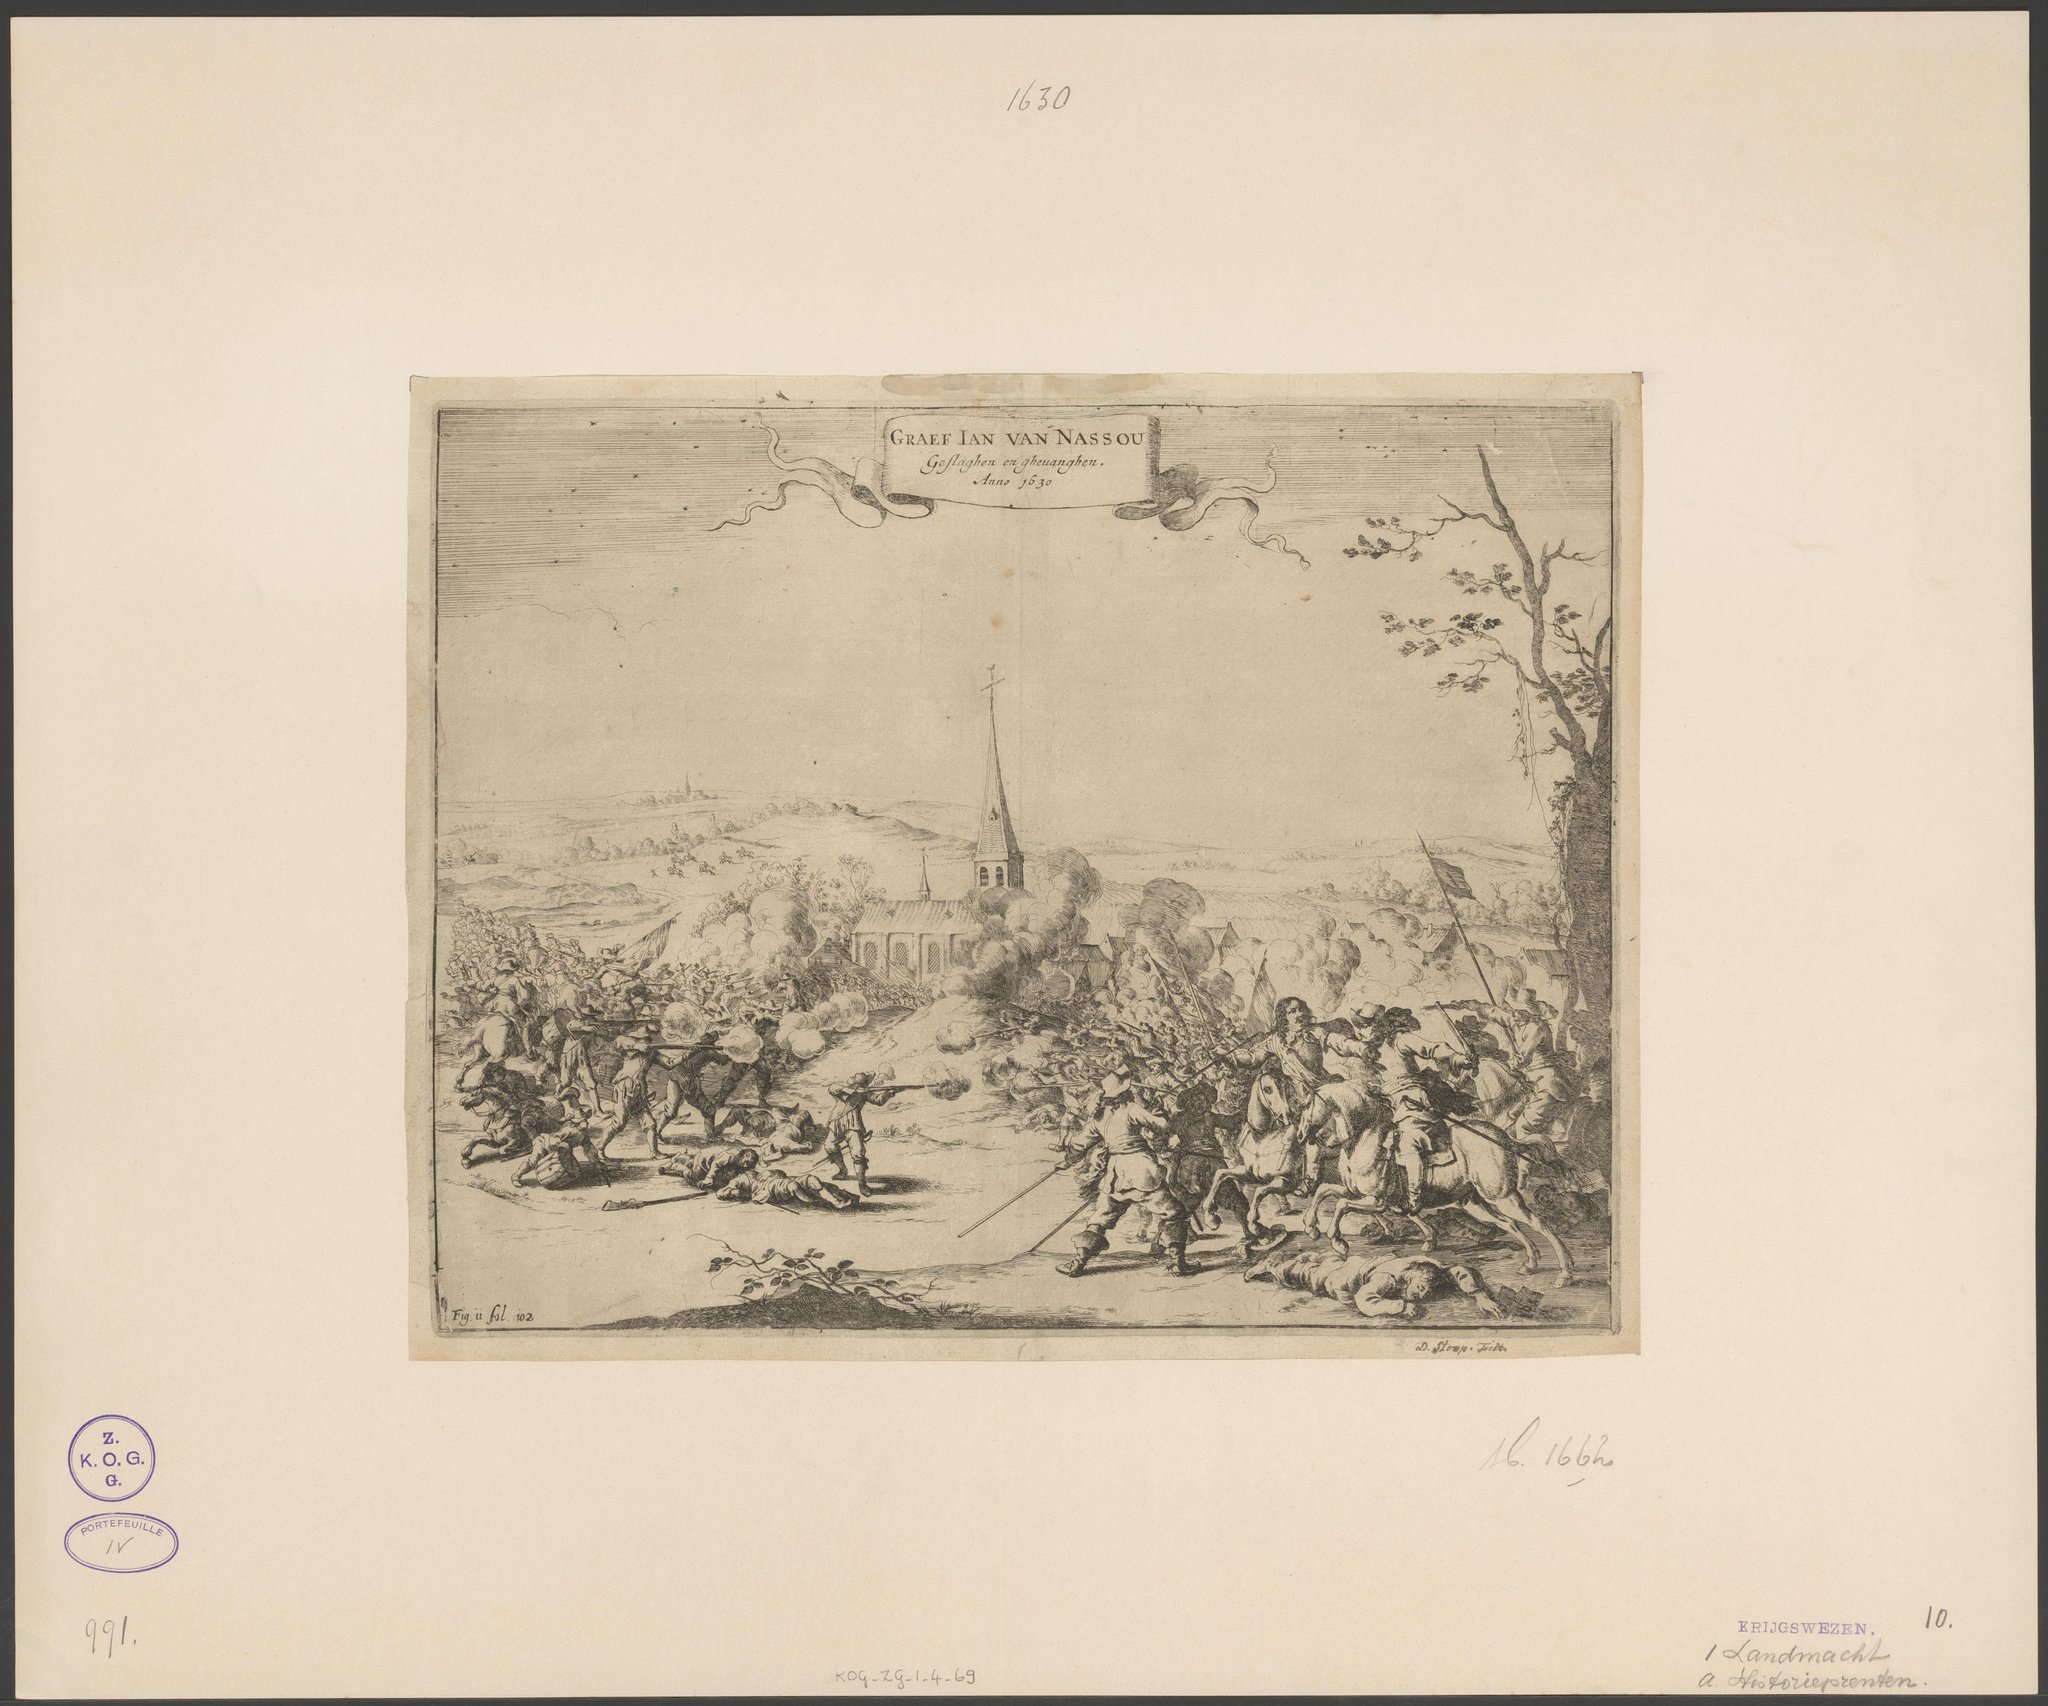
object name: history print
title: Graef Jan van Nassou Geslaghen en ghevanghen. Anno 1630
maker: dirk stoop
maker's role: draughtsman, painter, print maker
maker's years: 1615-1686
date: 1651-1652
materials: paper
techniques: etching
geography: northern netherlands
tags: battle (+ land forces)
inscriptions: collector's mark: Lugt 1641, collector's mark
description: Gebruikt als illustratie in: Jacobus Kok, Vaderlandsch Woordenboek, Johannes Allart, Amsterdam 1785-1799, 35 delen, dl. XVII, pl. II. Staat met de letter.